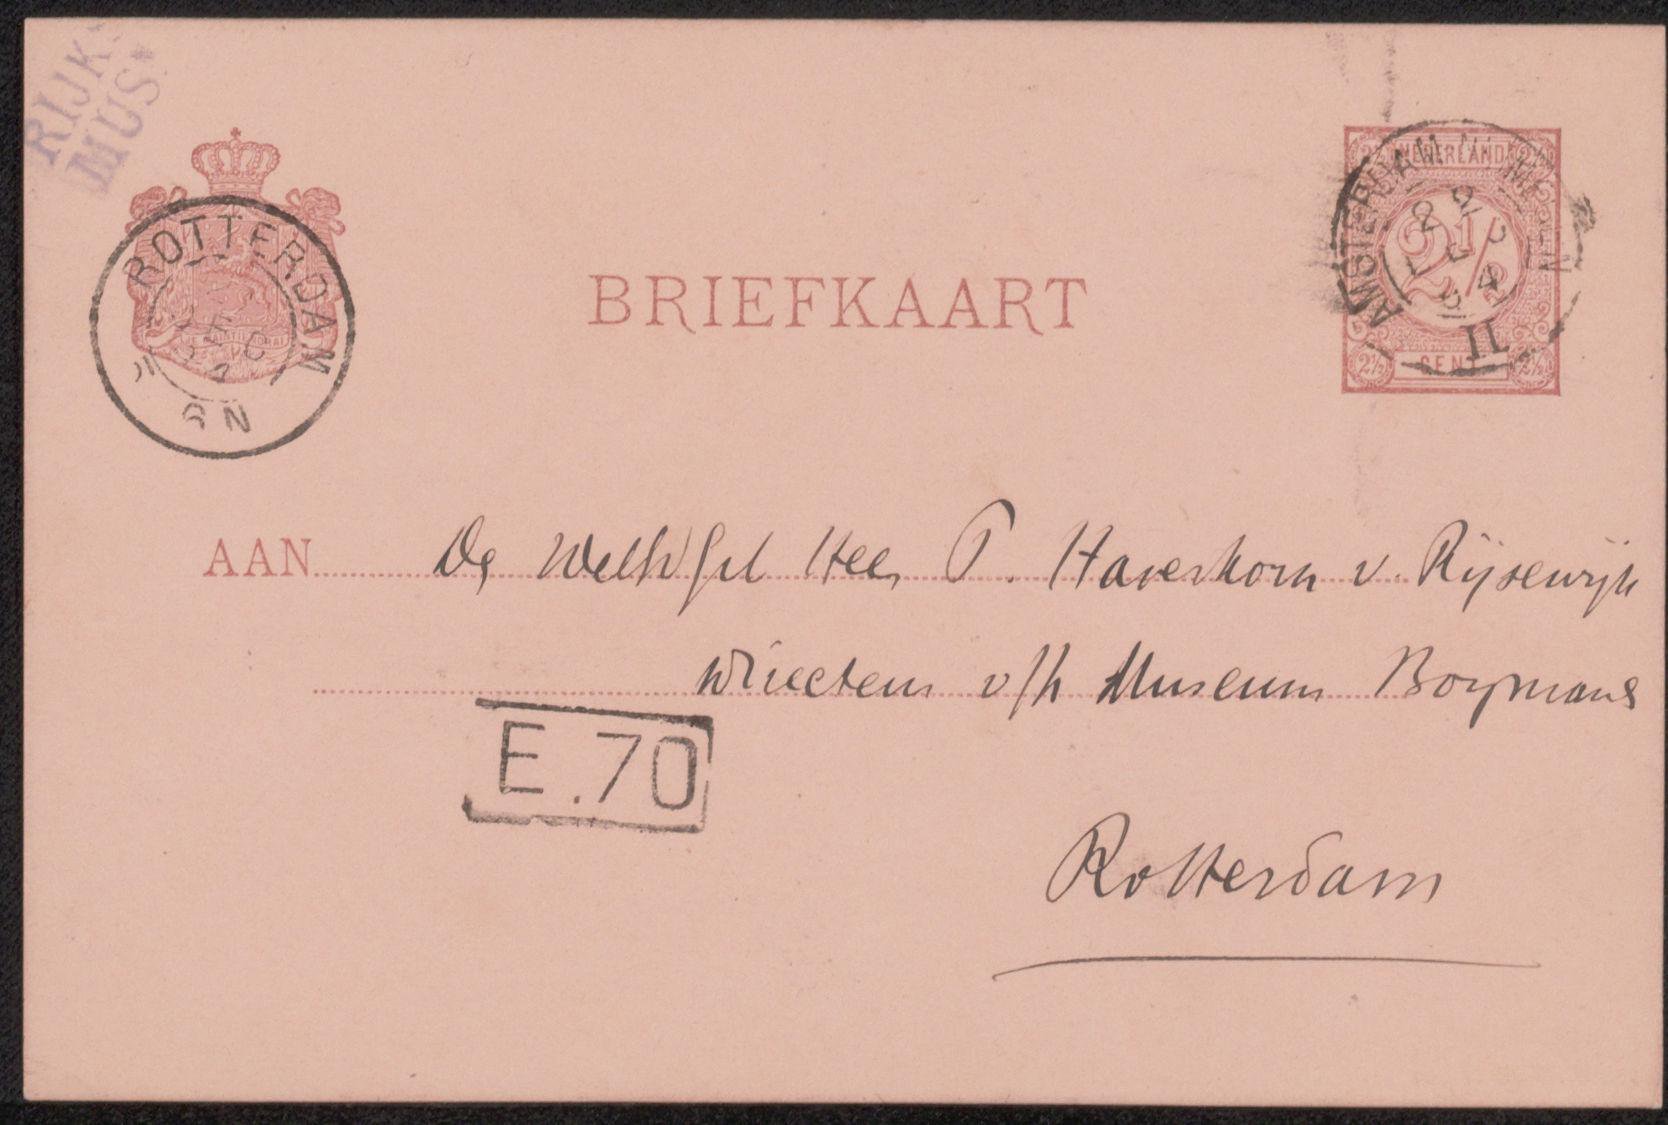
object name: postcard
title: Briefkaart aan Pieter Haverkorn van Rijsewijk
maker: jan veth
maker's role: designer, draughtsman, painter, print maker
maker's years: 1864-1925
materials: cardboard, ink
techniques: pen, writing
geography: bussum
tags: pieter haverkorn van rijsewijk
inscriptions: collector's mark: Lugt 2166